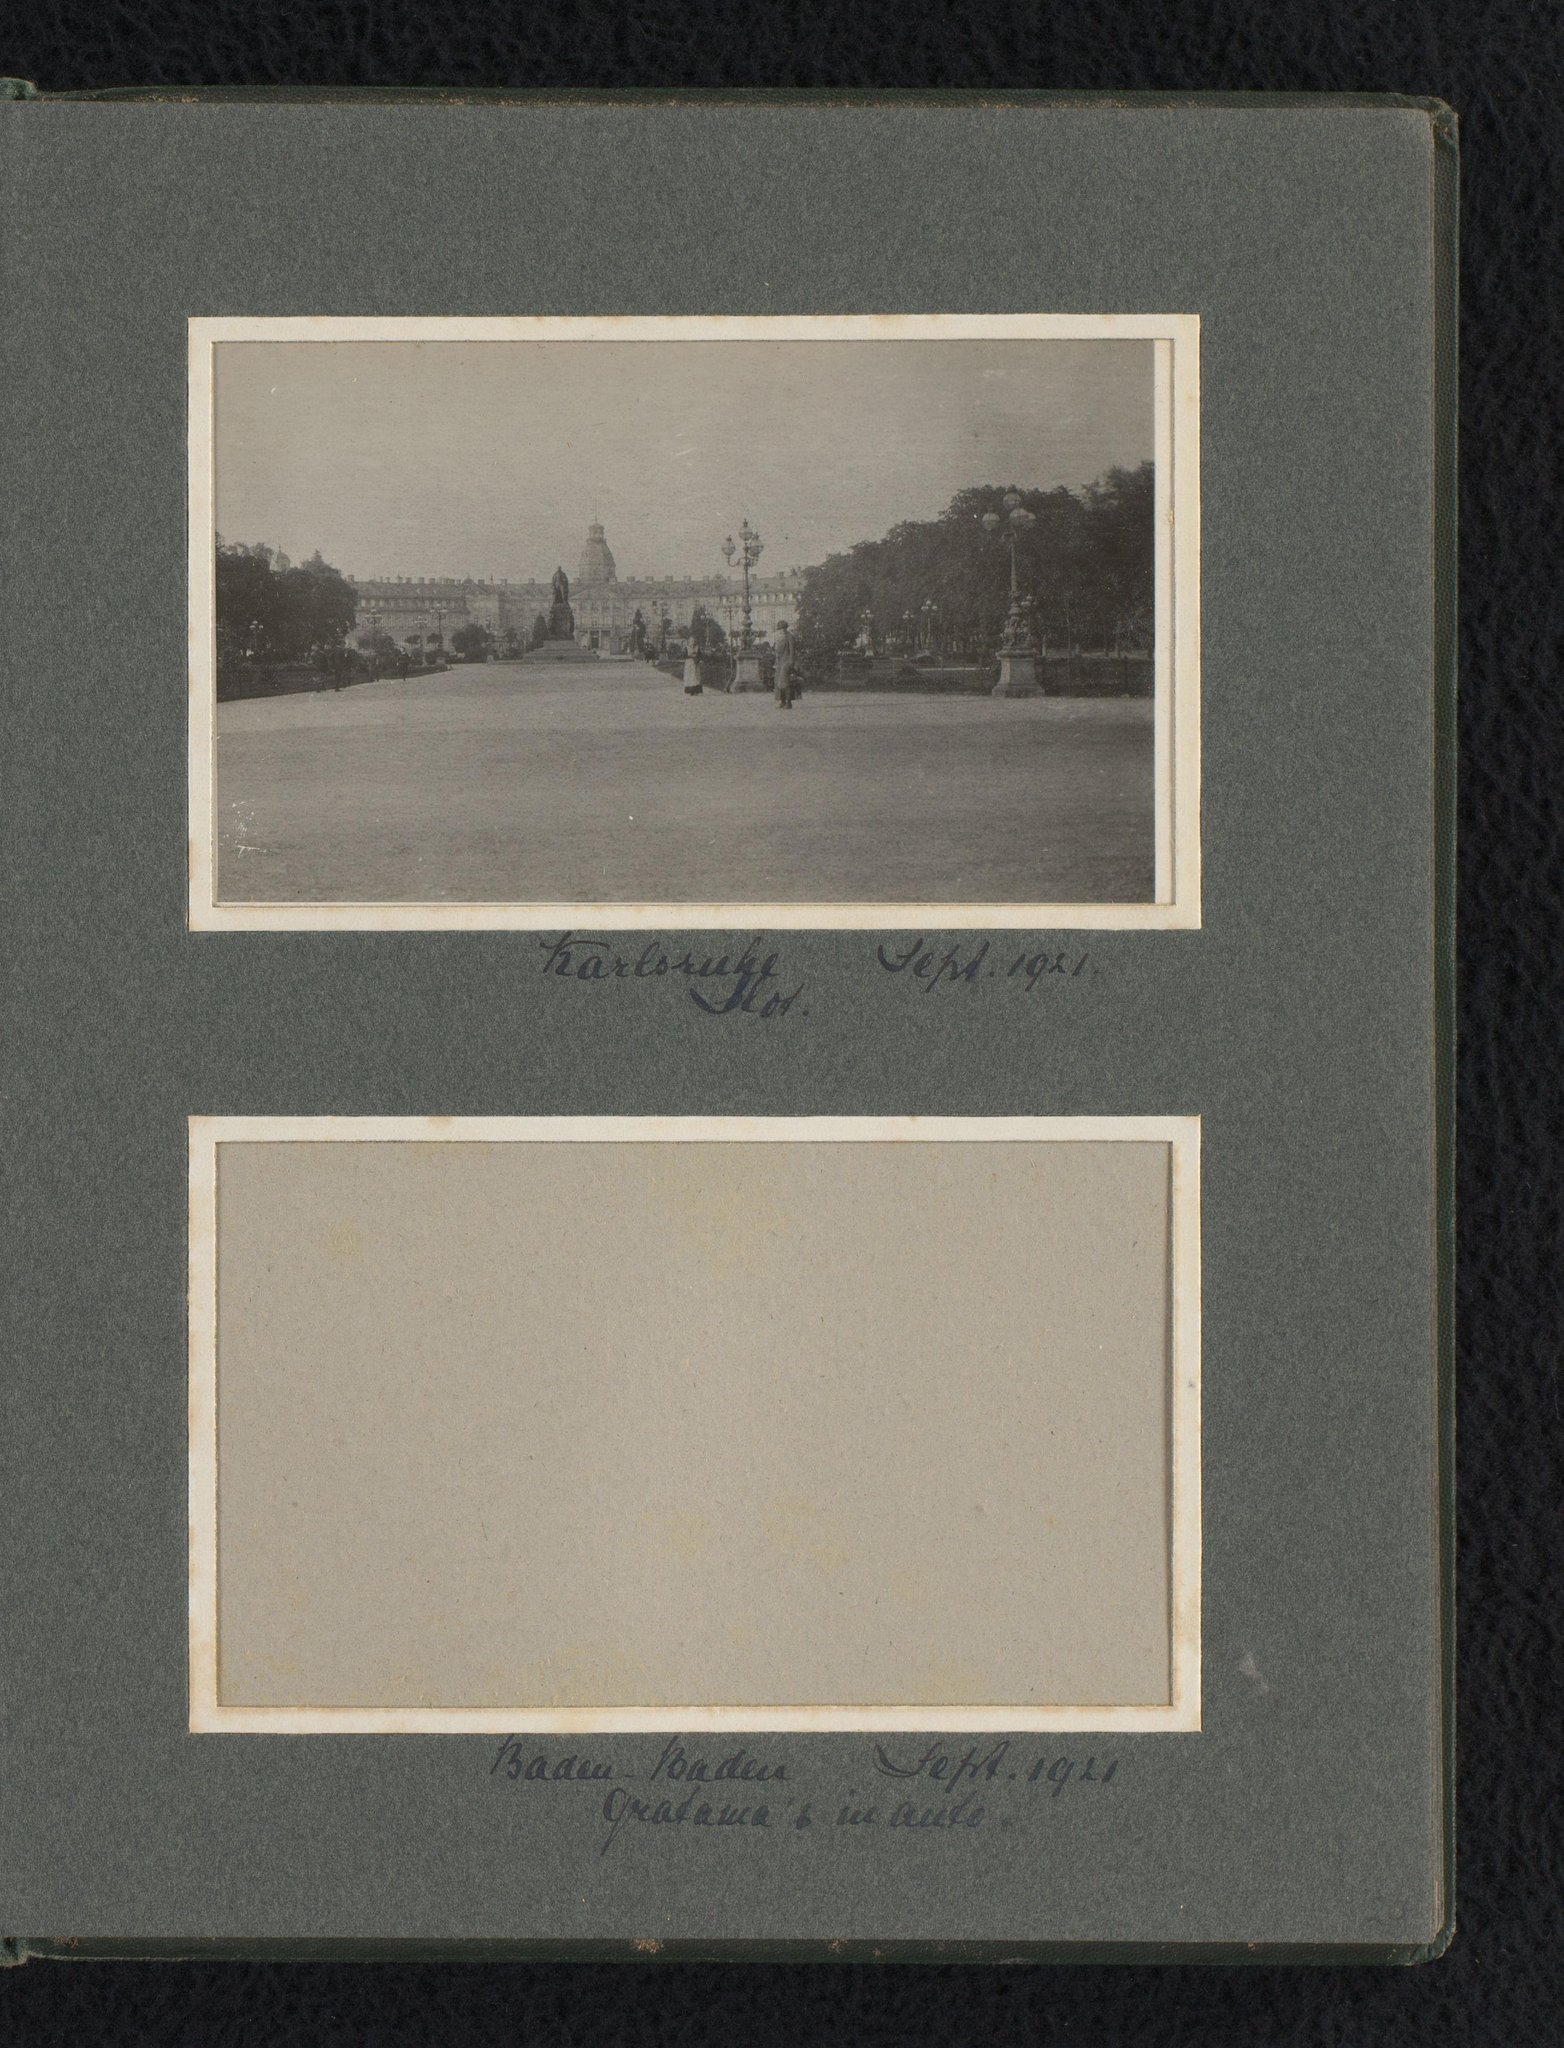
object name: photograph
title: Gezicht op slot Karlsruhe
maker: hendrik herman van den berg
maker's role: amateurfotograaf, jurist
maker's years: 1875-1944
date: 1909-1921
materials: paper, cardboard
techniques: gelatin silver print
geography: karlsruhe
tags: palace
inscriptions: caption: ‘Karlsruhe Sept. 1921/ Slot./ Baden-Baden Sept. 1921/ [...] in auto’